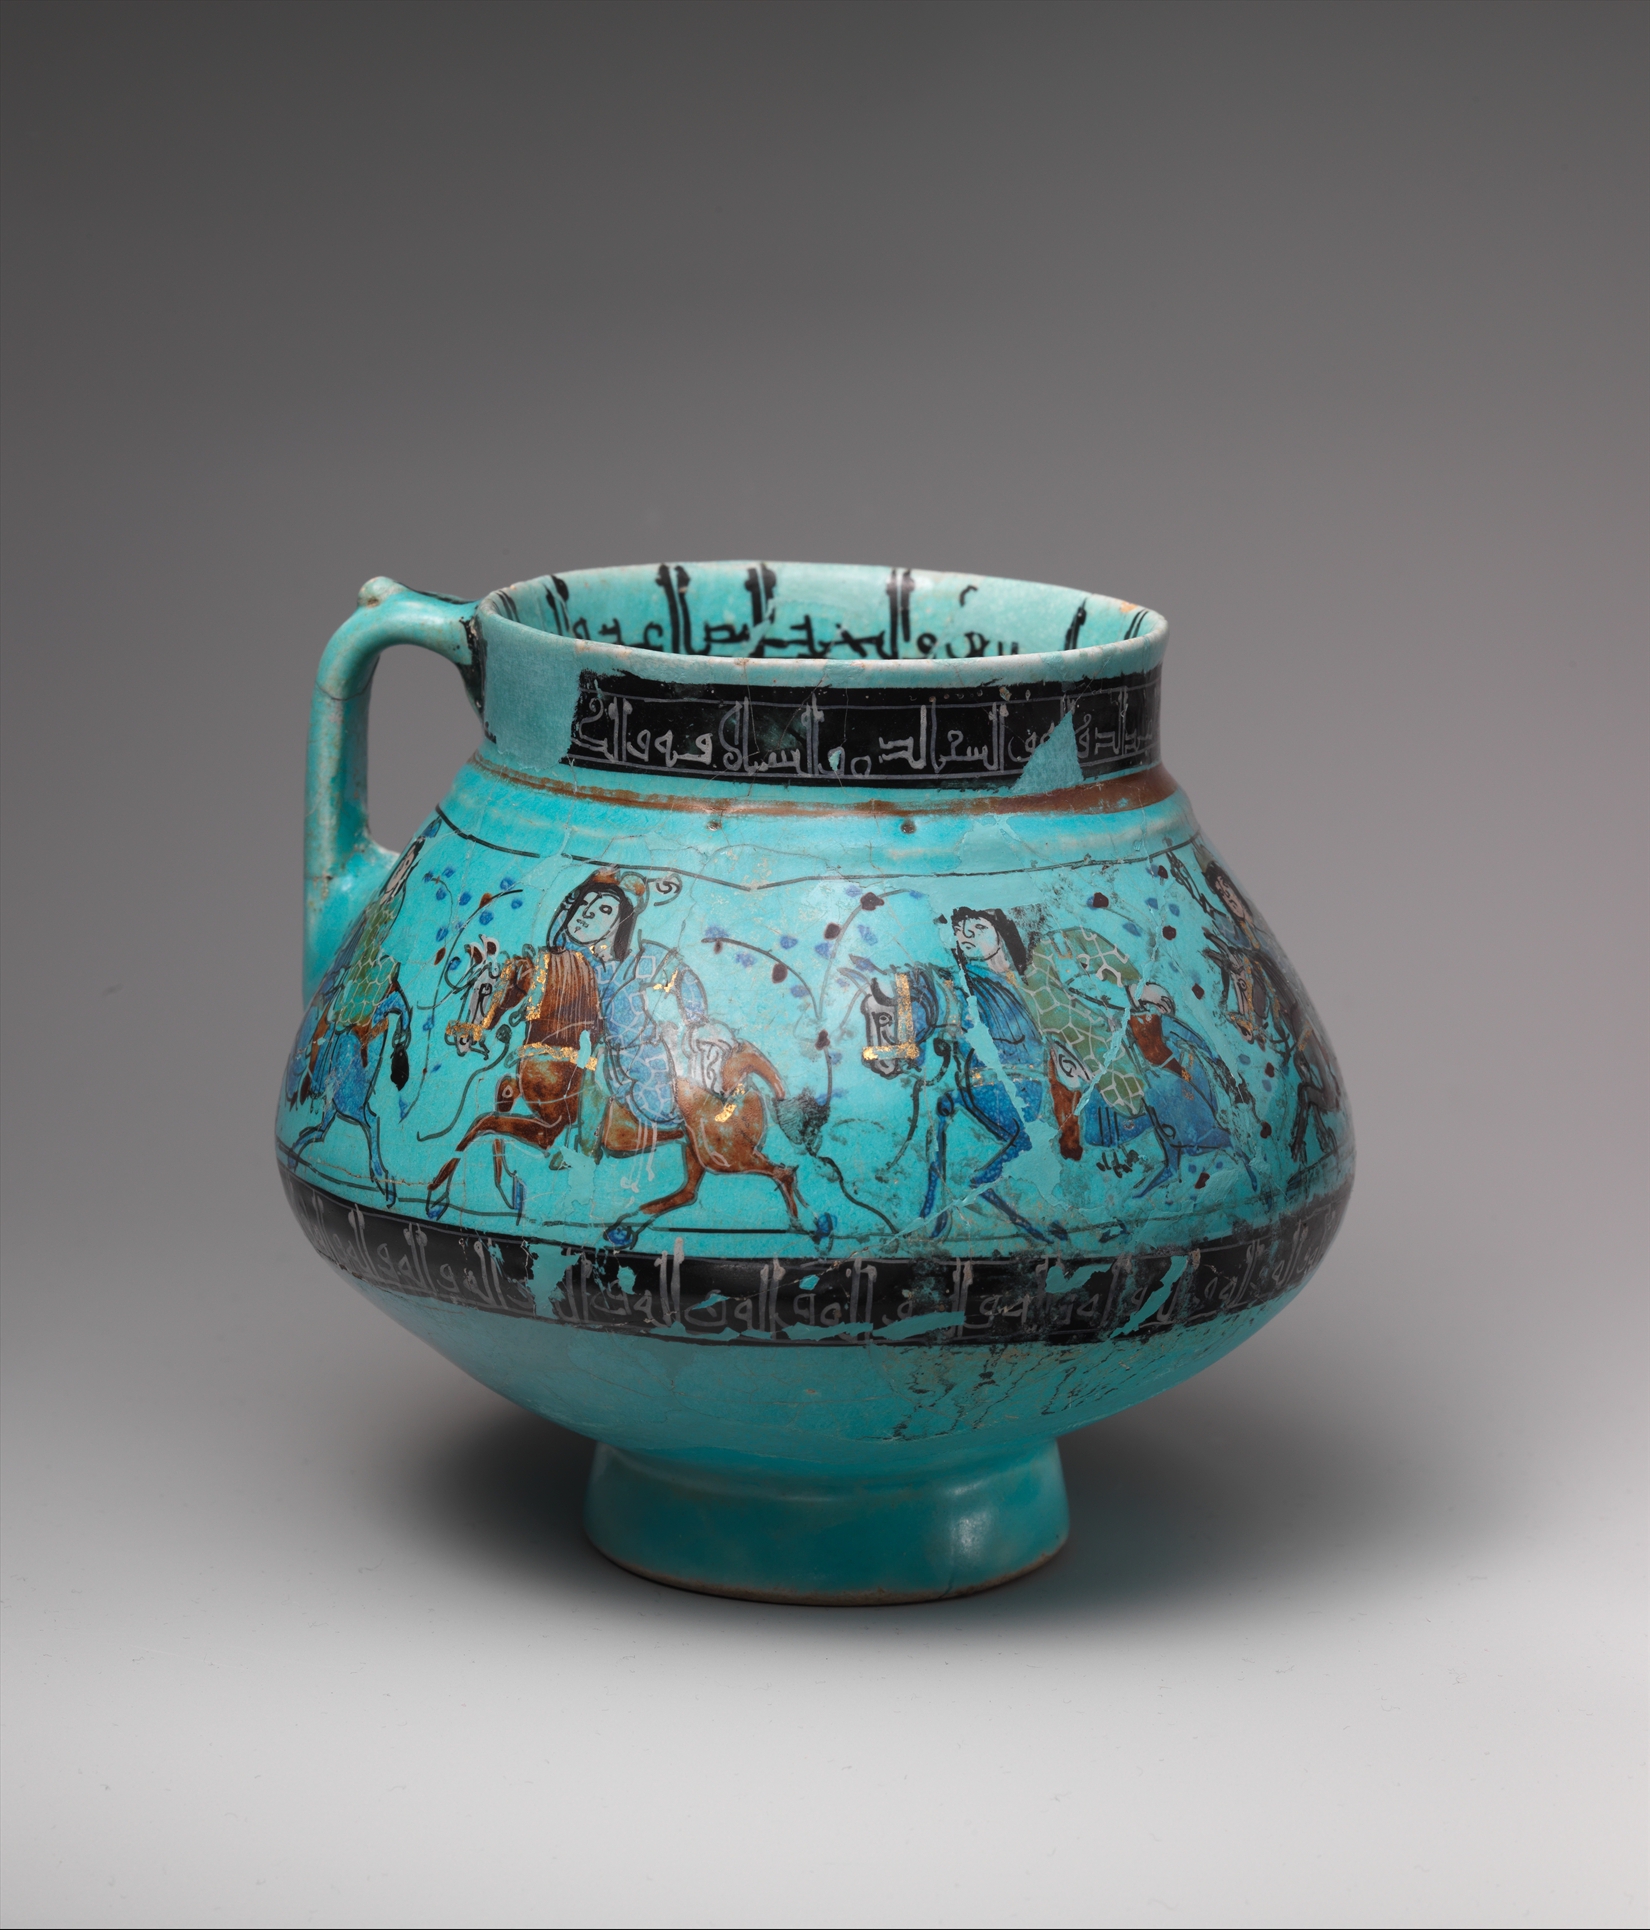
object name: ewer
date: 1101-1300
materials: stonepaste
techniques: overglaze, painting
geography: iran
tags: human figures,horses